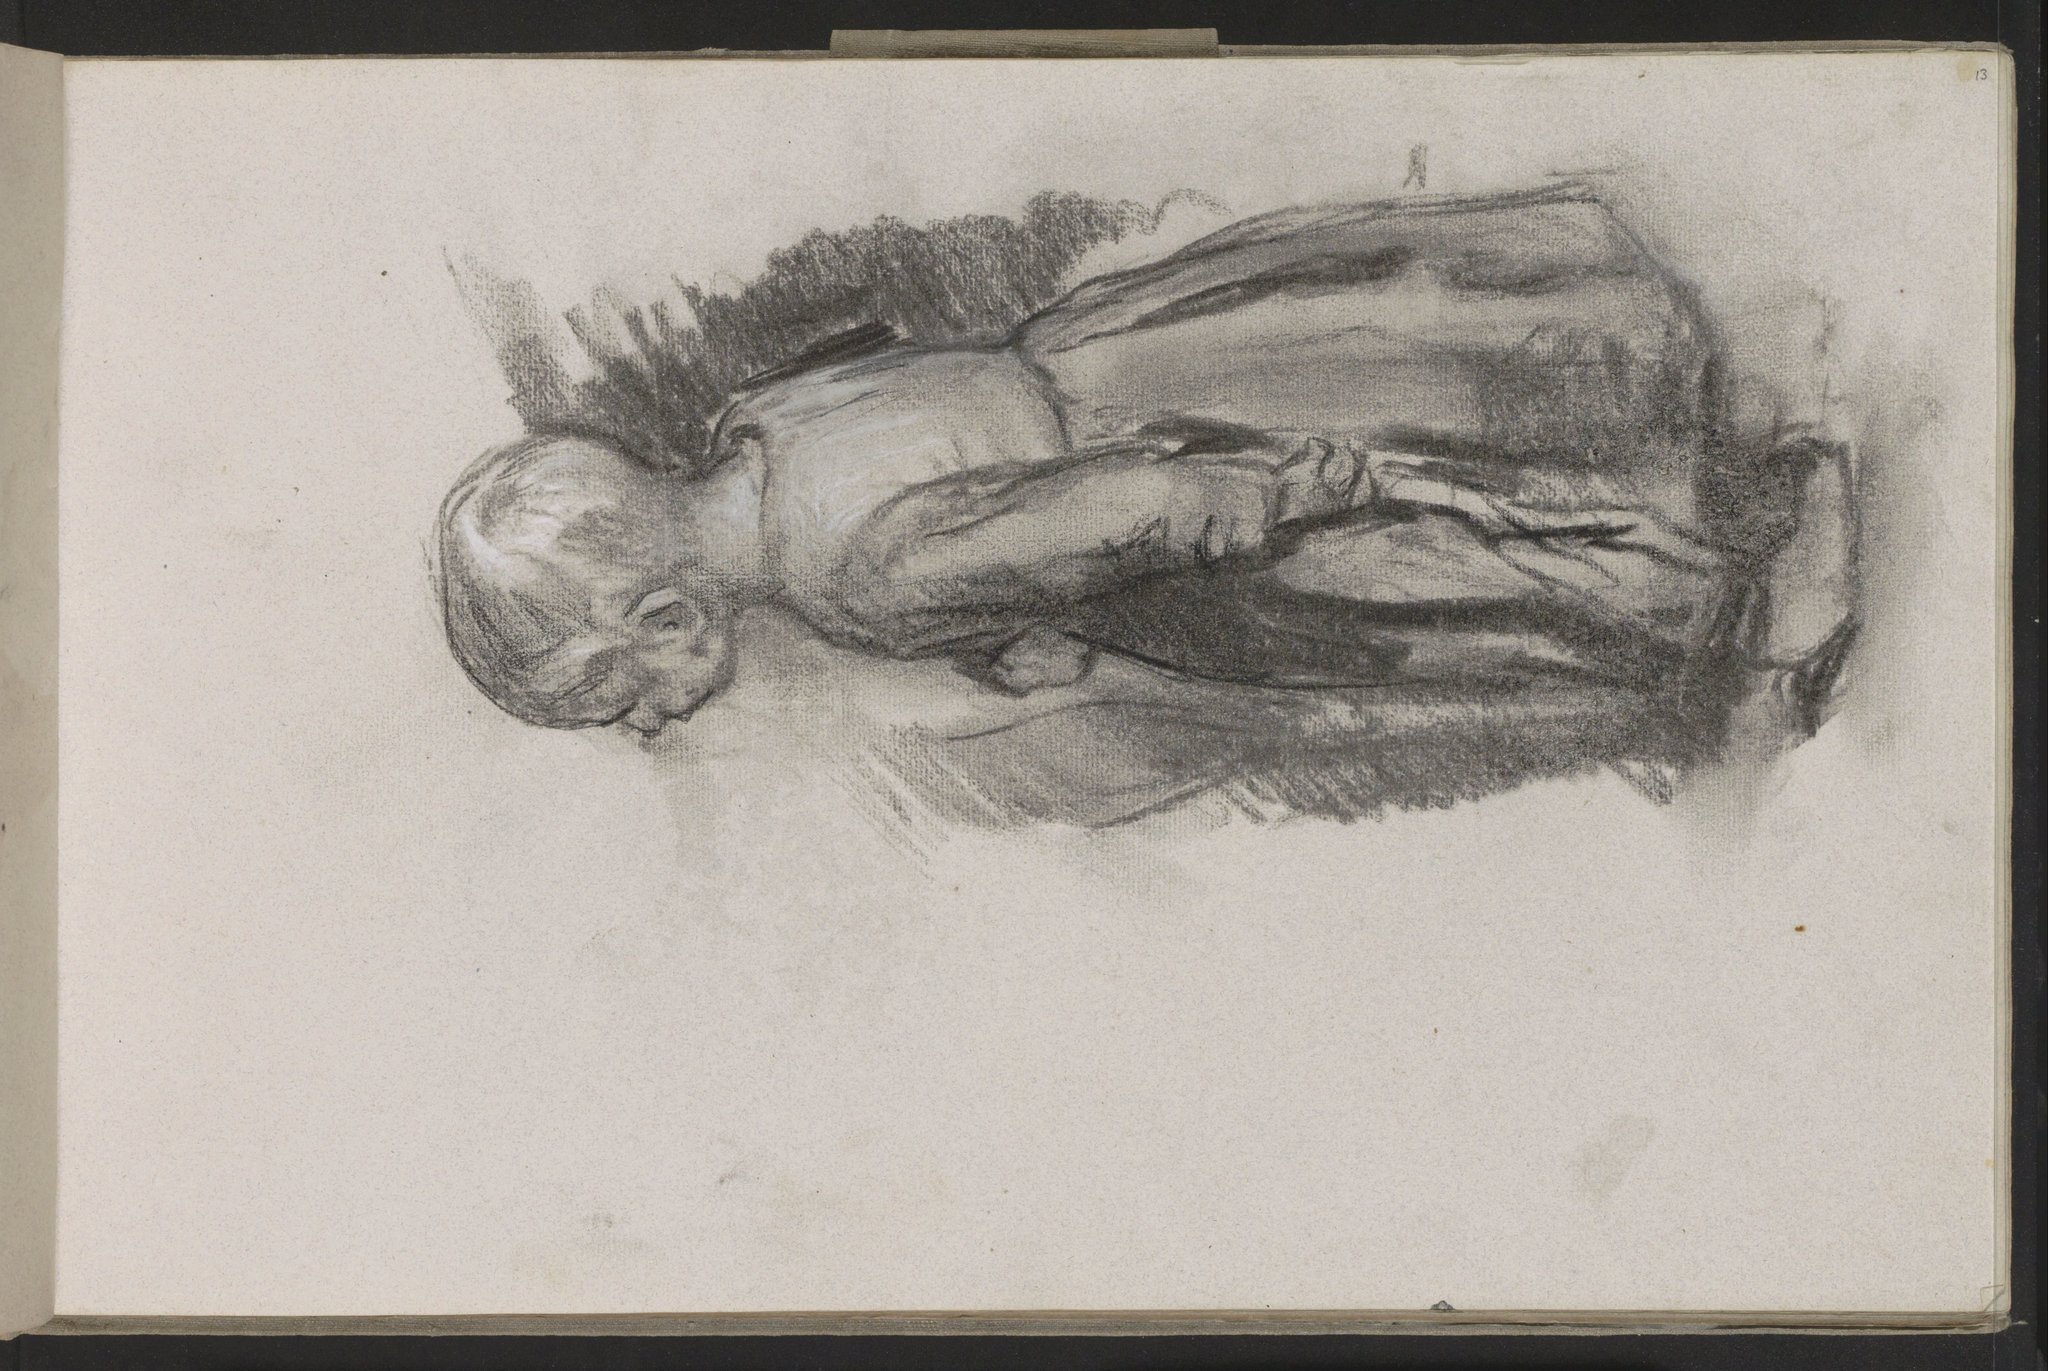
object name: sketchbook leaf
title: Peutermeisje op klompen, van opzij gezien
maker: albert neuhuys (1844-1914)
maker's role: draughtsman, painter, print maker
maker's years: 1844-1914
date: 1854-1914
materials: charcoal, paint, paper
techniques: brush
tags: wooden shoes, clogs, toddler (female)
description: Het kind draagt vermoedelijk een stok in de hand. Blad 13 recto uit een schetsboek met 51 bladen.